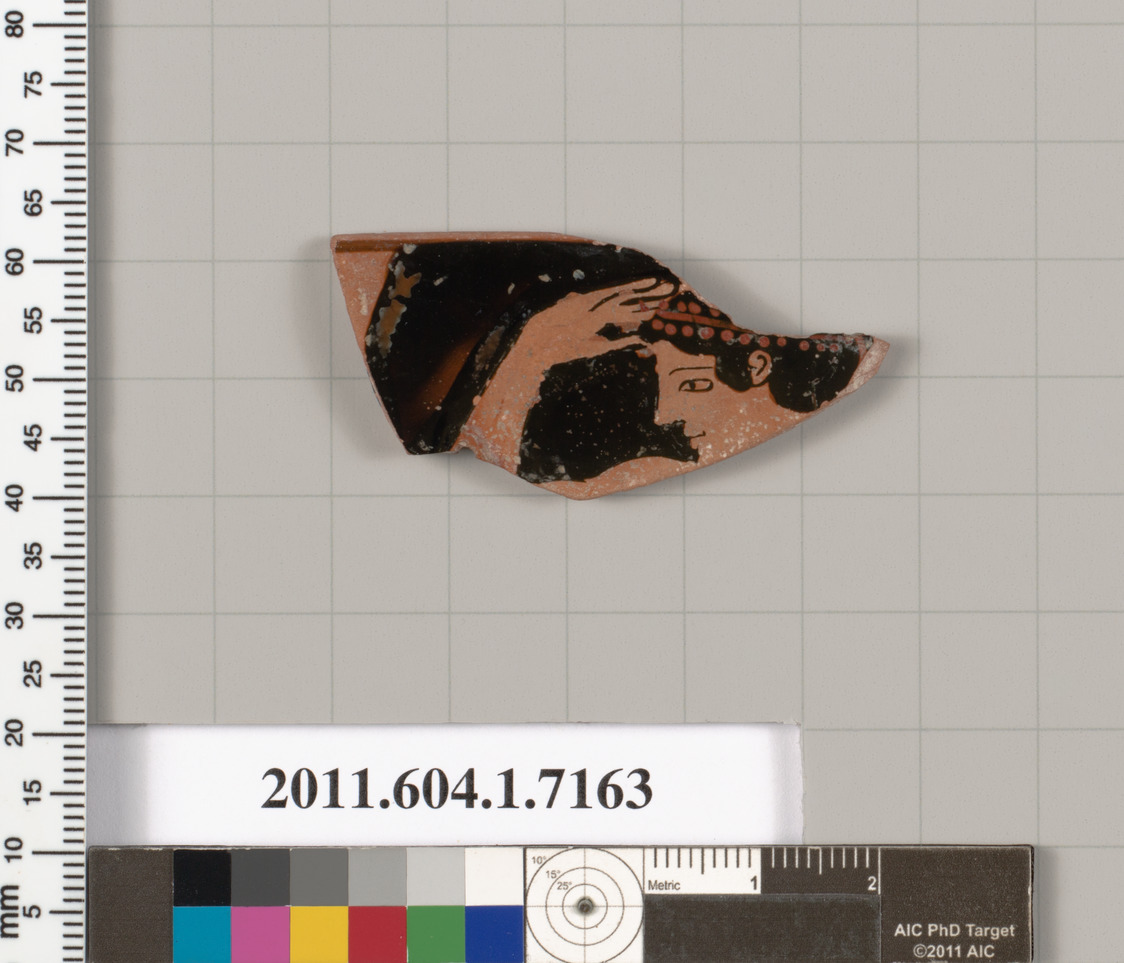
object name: kylix fragment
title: Terracotta rim fragment of a kylix (drinking cup)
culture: greek, attic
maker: makron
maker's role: artist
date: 500-480 BCE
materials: terracotta